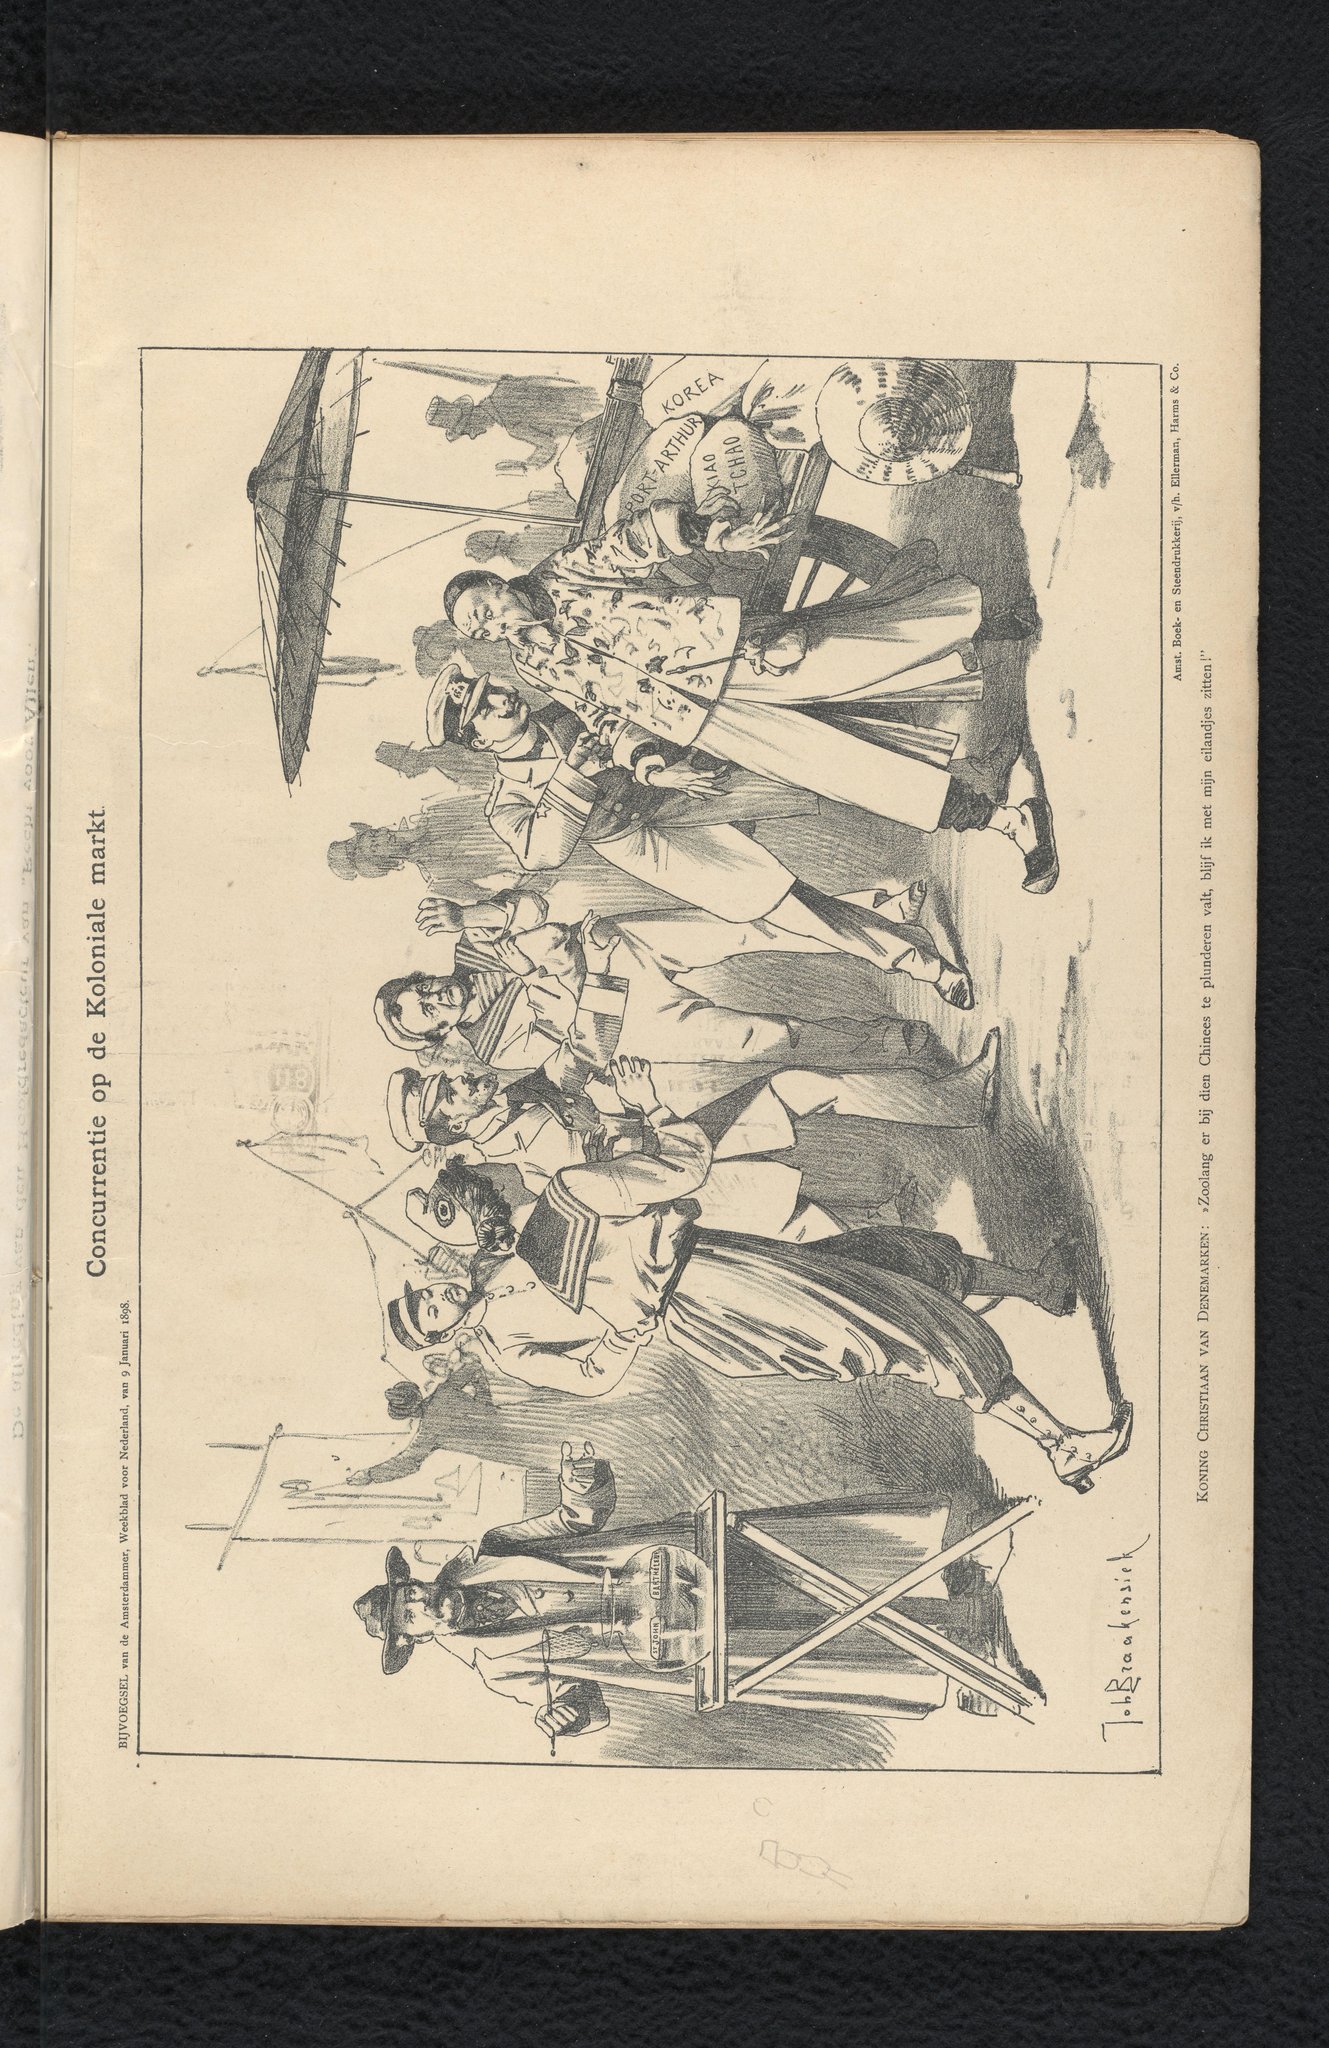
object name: cartoon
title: Concurrentie op de Koloniale markt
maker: johan braakensiek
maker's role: draughtsman, print maker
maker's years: 1858-1940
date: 1898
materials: paper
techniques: lithograph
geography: amsterdam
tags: personifications of countries, nations, states, districts, etc., market, political caricatures and satires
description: Europese mogendheden vallen een Chinese marktkoopman aan om zijn bezittingen te stelen. Er is geen interesse in de waar bij het stalletje van koning Christiaan van Denemarken, de West-Indische eilandjes Saint John en Saint-Barthélemy.